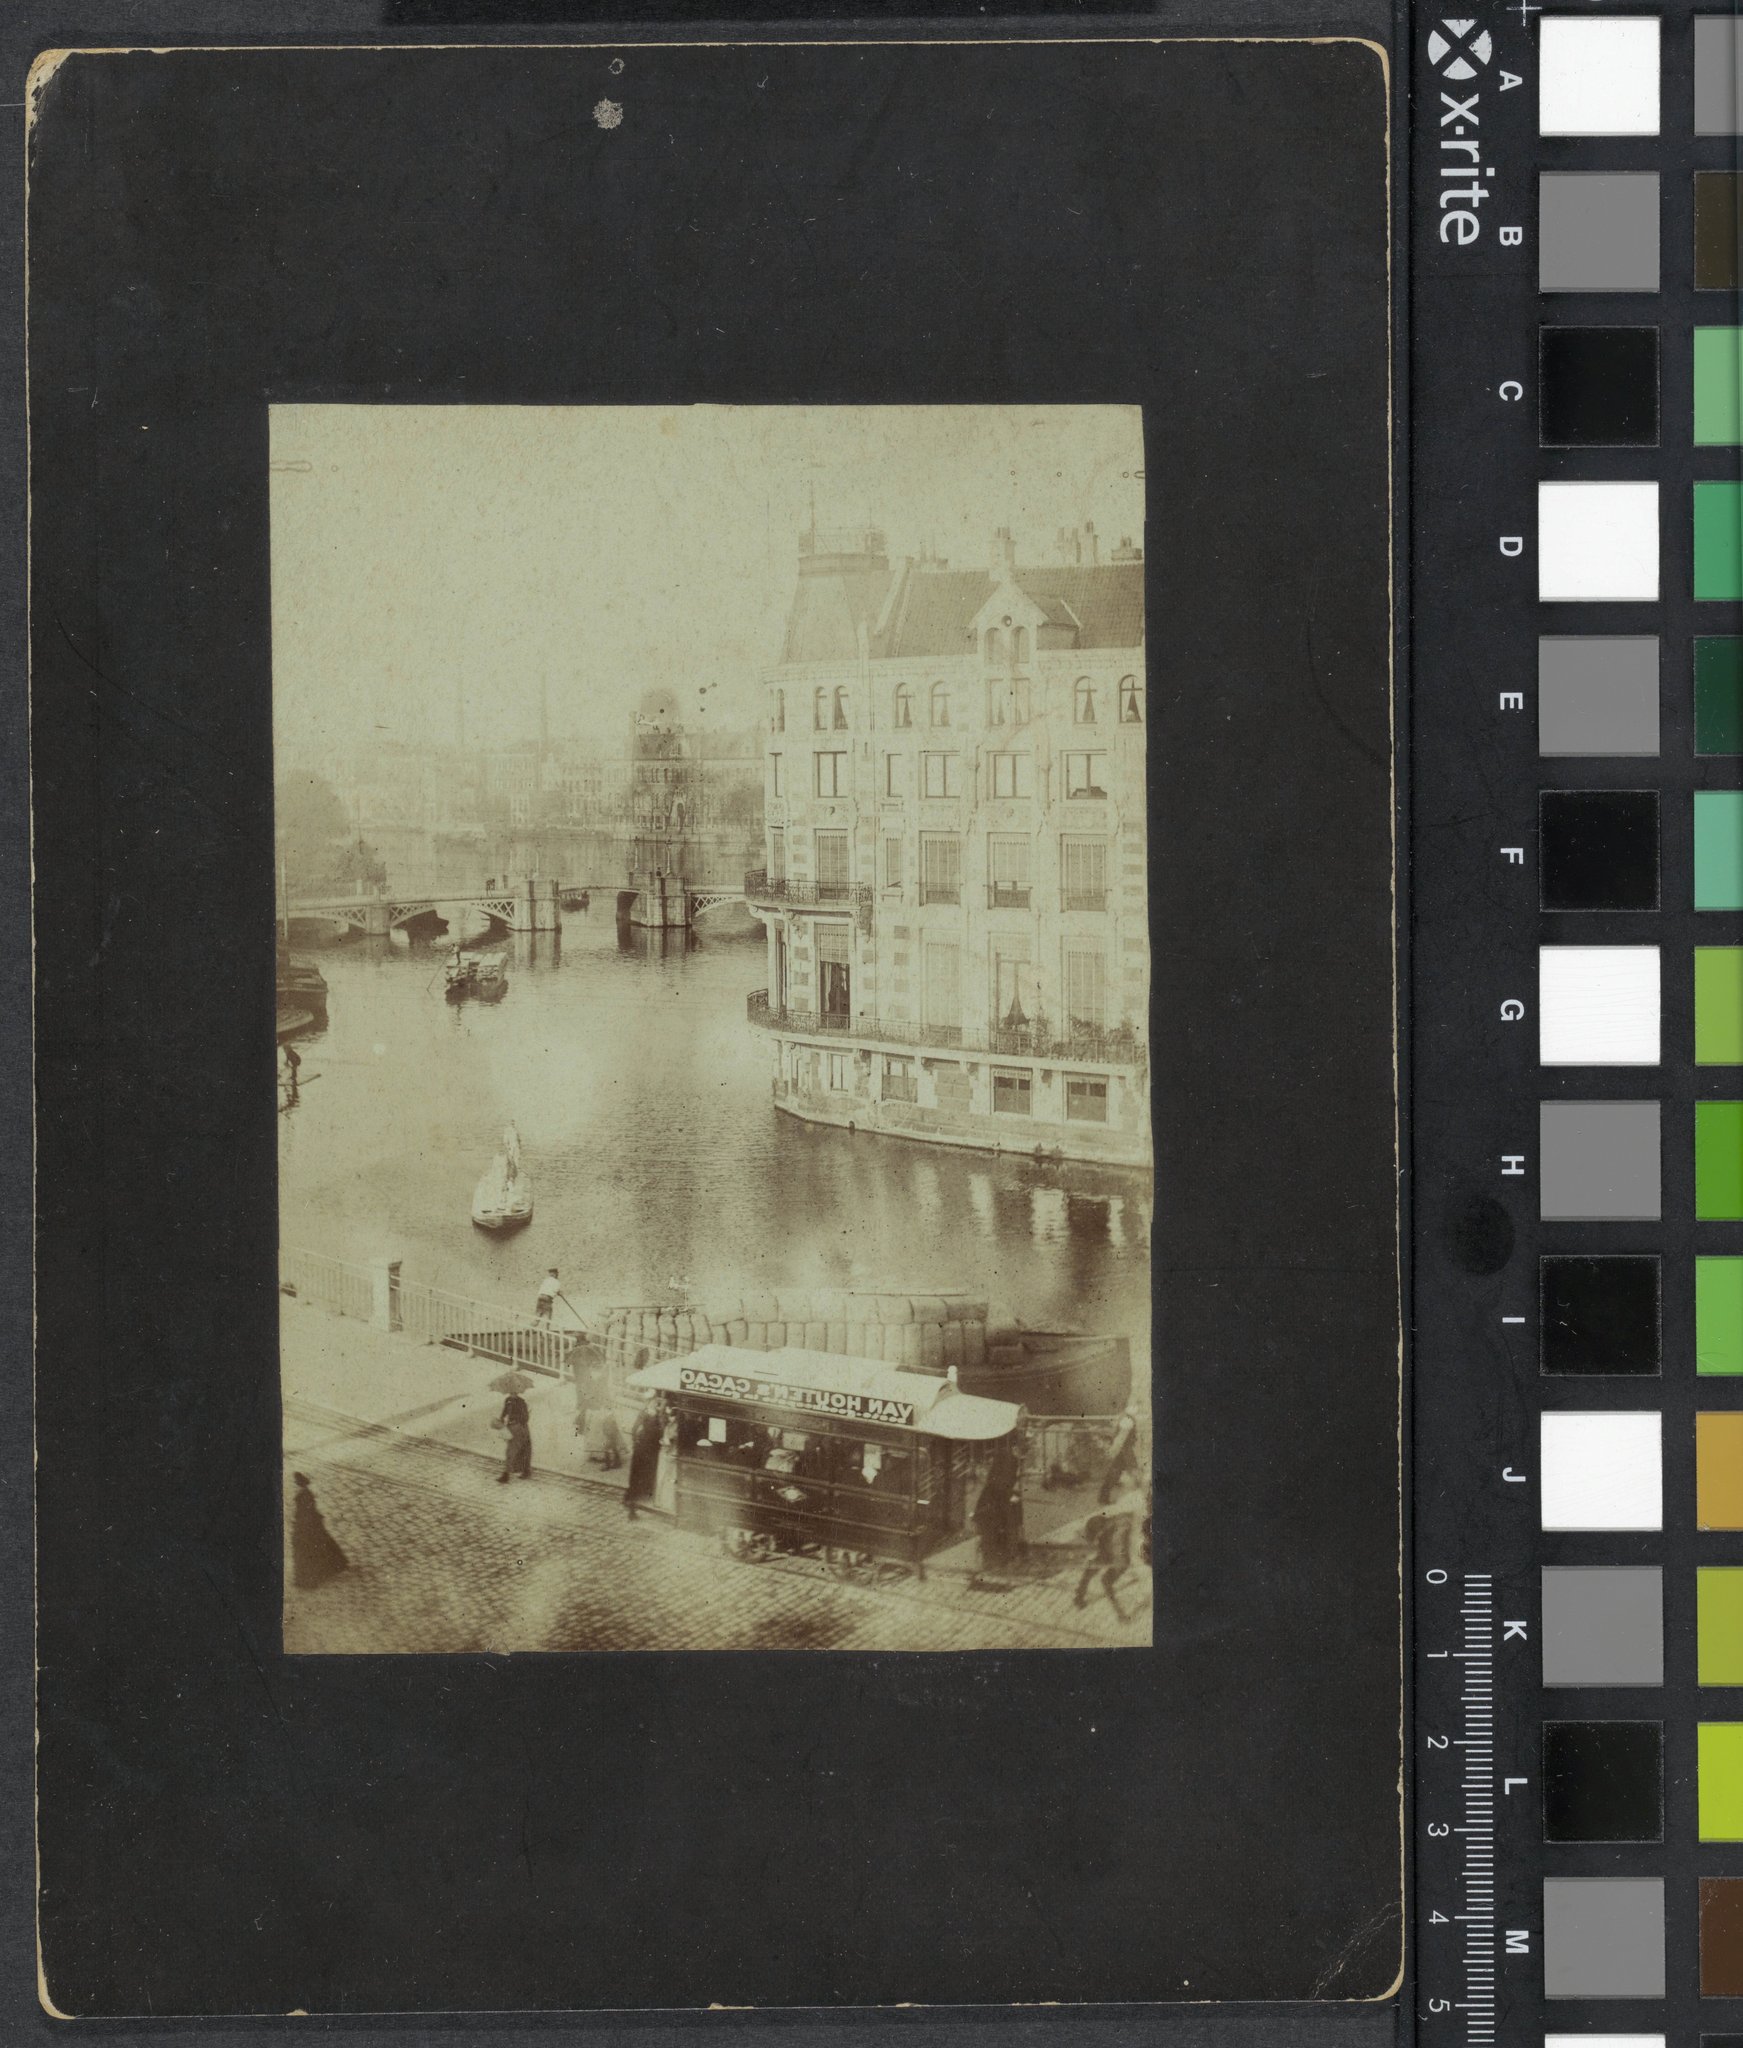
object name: photograph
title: Gezicht op een gracht met op de voorgrond een paardentram met reclame voor Van Houten's Cacao, mogelijk in Amsterdam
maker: Anonymous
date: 1870-1890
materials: cardboard, paper, photographic support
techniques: albumen print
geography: amsterdam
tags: diligence, omnibus, horse-tram, canal, amsterdam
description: Binnen Amstel te Amsterdam, gezien naar het Muntplein. Op de voorgrond een paardentram met reclame voor Van Houten's Cacao.